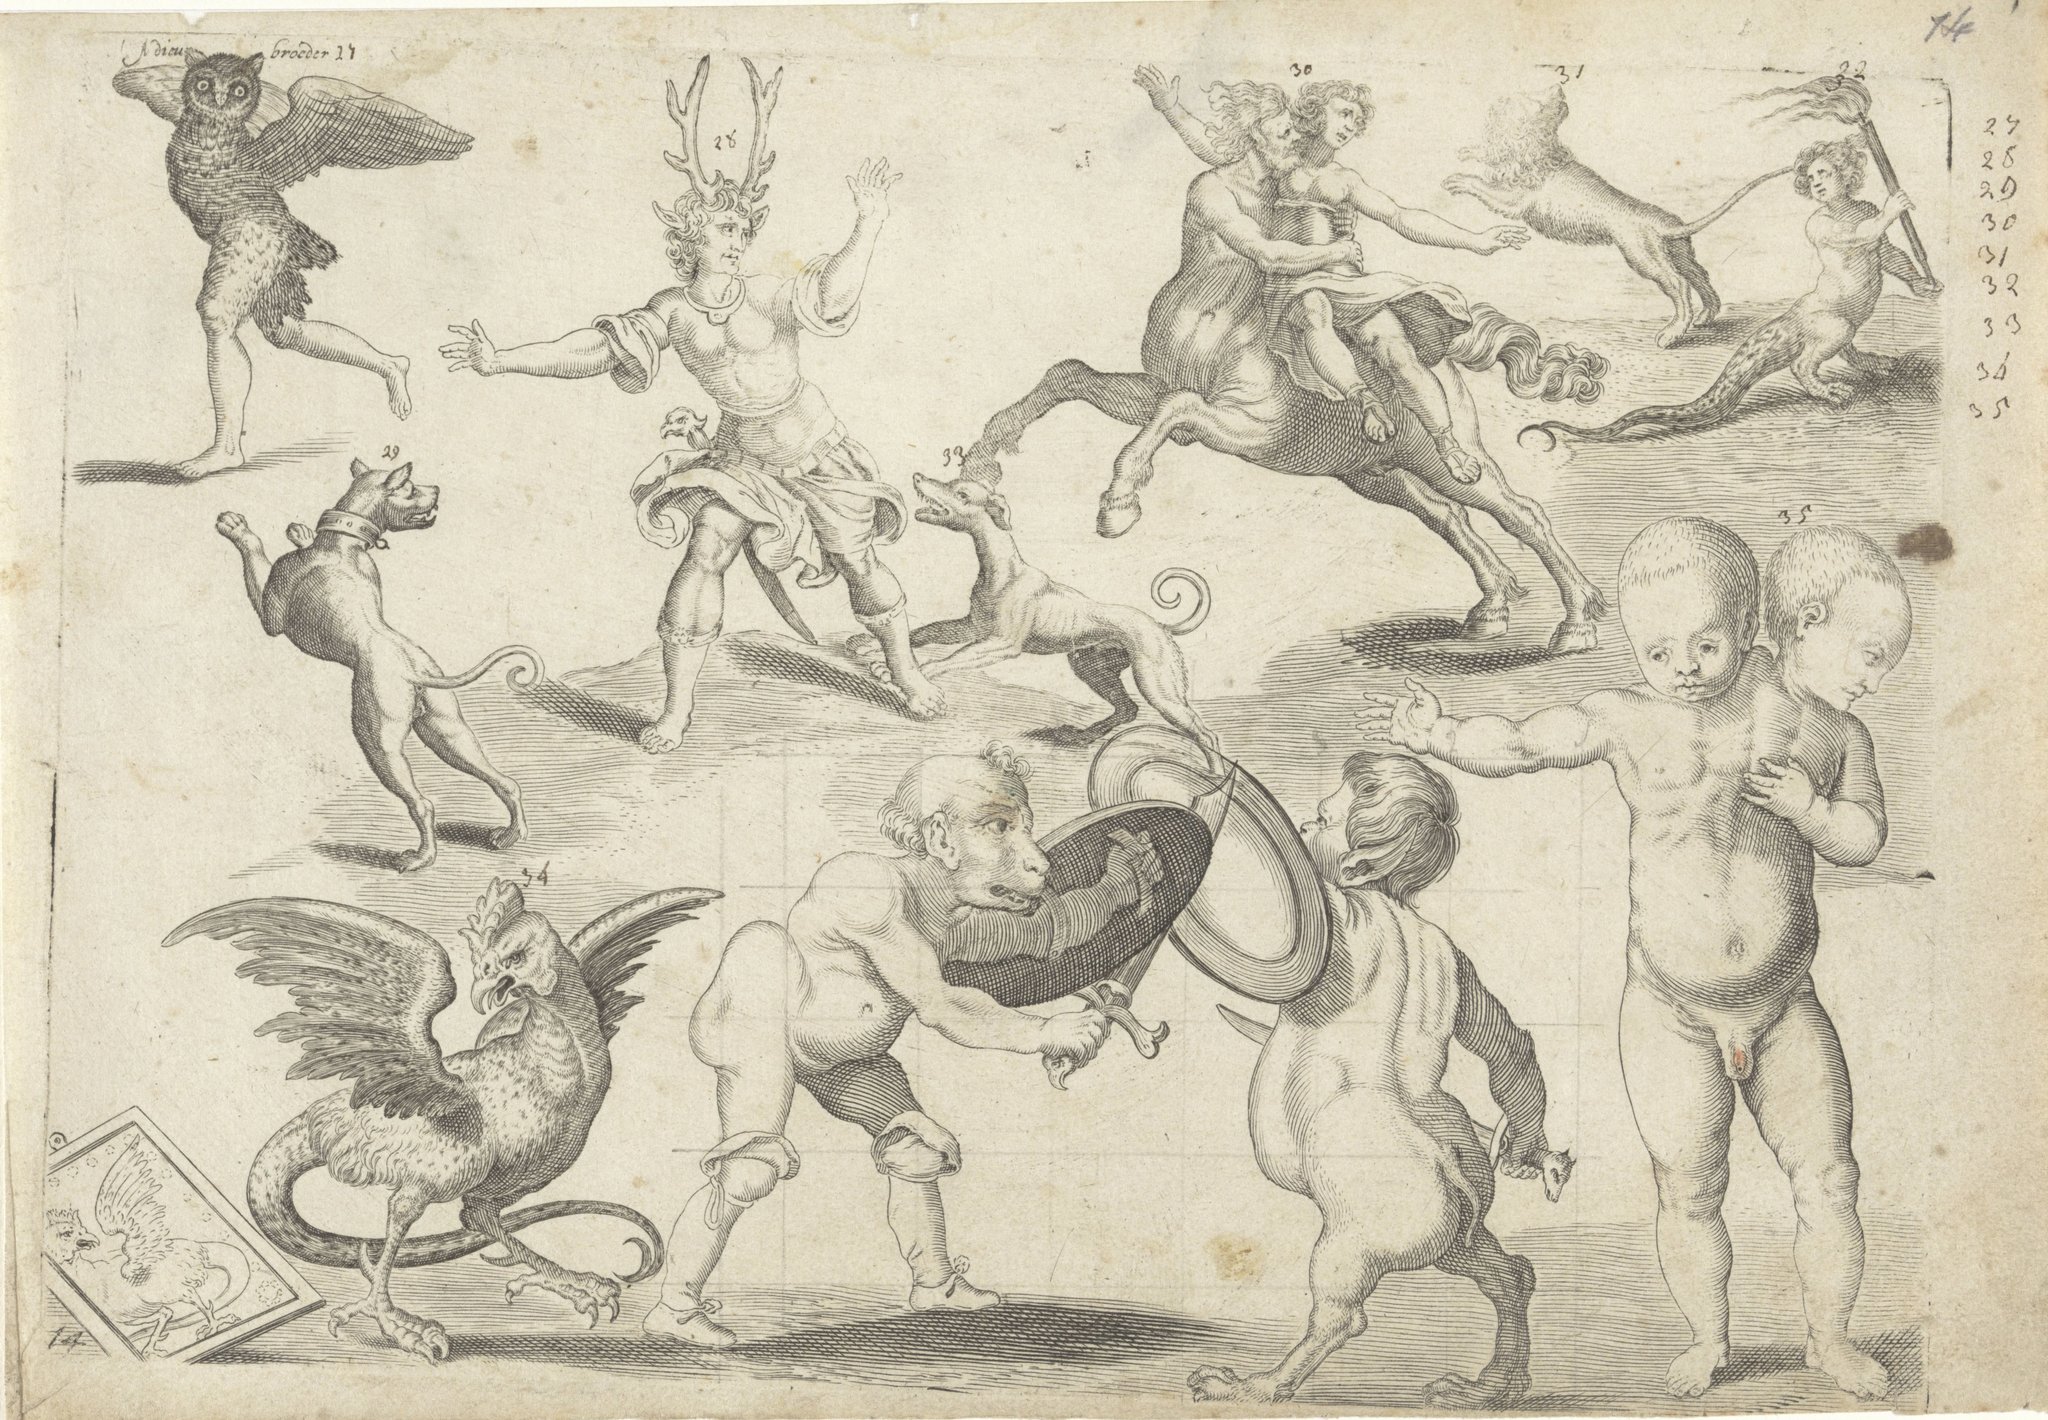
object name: print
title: Studieblad met tekenvoorbeelden: fabeldieren en rariteiten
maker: michael snijders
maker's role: print maker, publisher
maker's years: 1586-1672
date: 1610-1672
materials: paper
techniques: engraving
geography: antwerp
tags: model-books ~ implements of painter, centaurs (in general) - love-affairs, monsters of mixed human and animal shape; 'mostri' (ripa), looking in the mirror; contemplation of own beauty, siamese twins, beasts of prey, predatory animals: lion, basilisk (cock with posterior of snake), dog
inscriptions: collector's mark: Lugt 2228, collector's mark: Lugt 2760, number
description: vgl. Arent van Bolten, RP-P-2004-24 en vgl. Hendrick Goltzius, Hollstein, deel 13, p.96, nr.256 Deze prent is ook gebruikt in een 17-eeuws knipwerk. De prent is uitgeknipt en met andere uitgeknipte prenten op blauw papier geplakt (zie: RP-P-2005-439).. Jan van der Waals, Prenten in de Gouden Eeuw, tent. cat. Boijmans van Beuningen (Rotterdam) 2006, p.44. nr.44